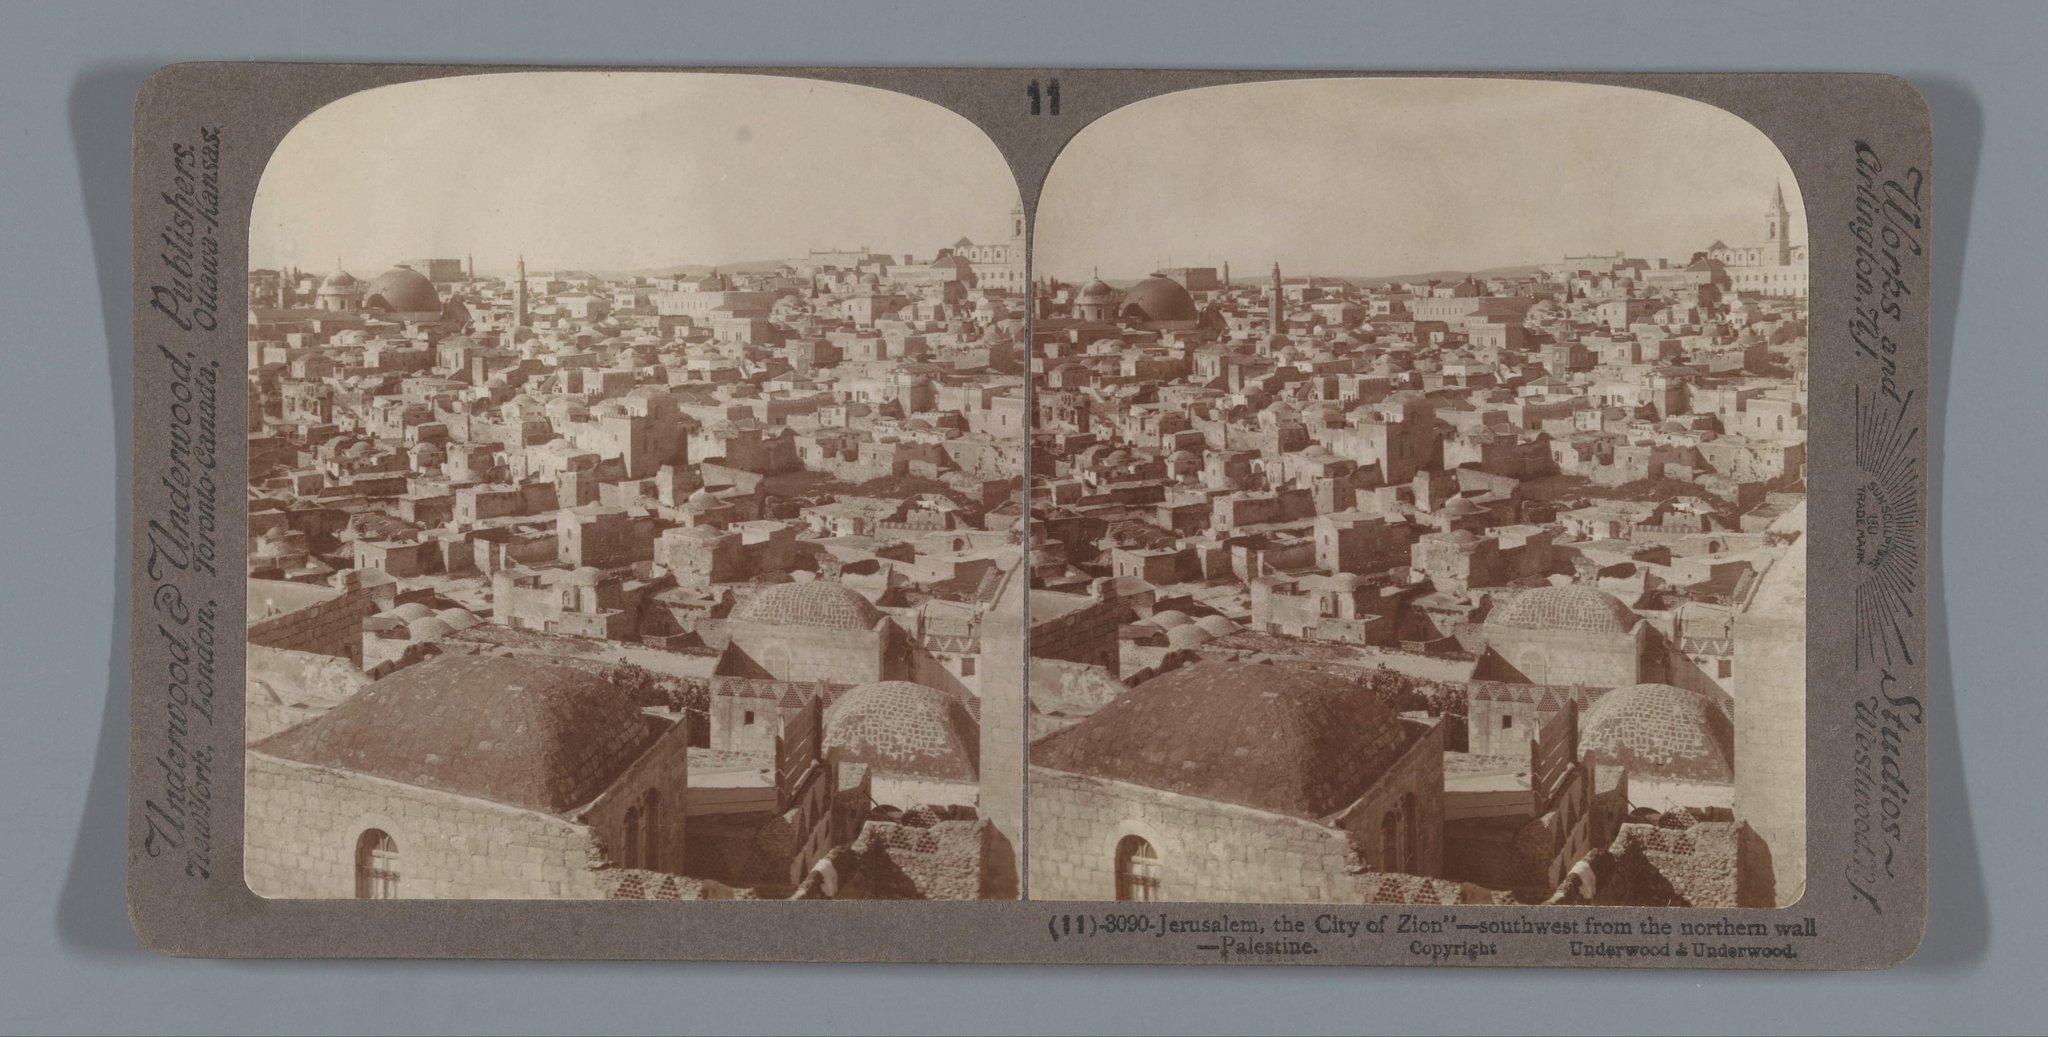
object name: stereograph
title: Gezicht op Jeruzalem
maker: Anonymous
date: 1900-1905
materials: paper, cardboard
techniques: gelatin silver print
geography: new york city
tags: city-view in general; 'veduta'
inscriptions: copyright notice: ‘Copyright Underwood & Underwood.’, inscription: ‘Works and Studios ~/ Arlington, N.J. Westwood, N.J.’, inscription, number: ‘10’, number: ‘(11)-3090-’